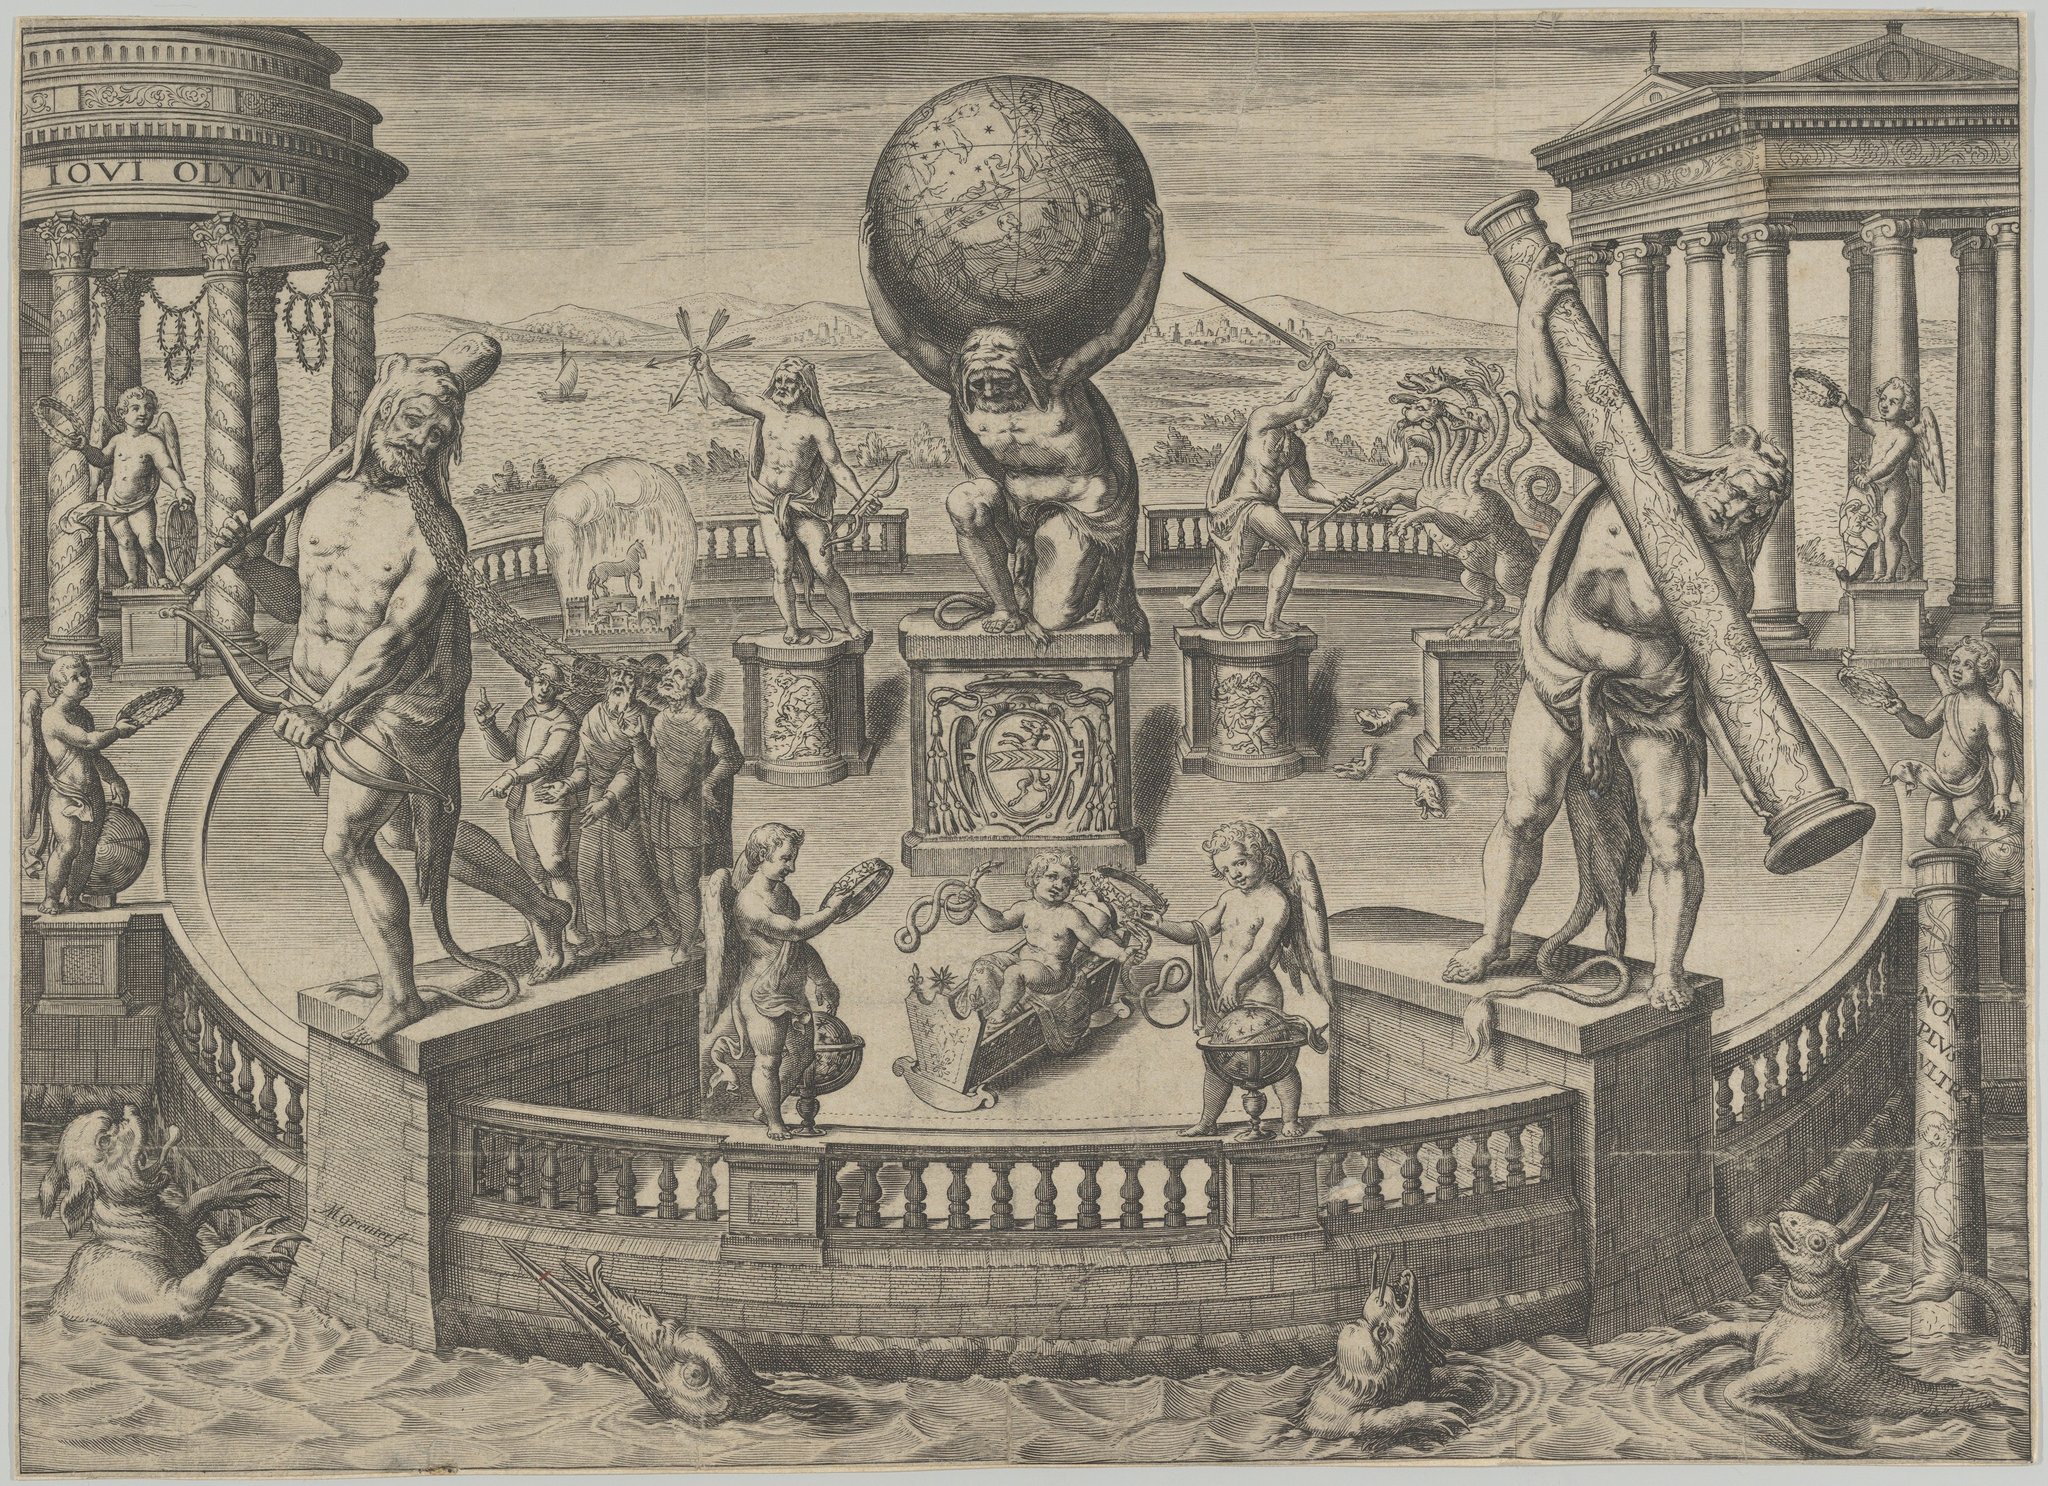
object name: print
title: Allegory of the Twelve Labors of Hercules Statues in a Circular Garden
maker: matthaeus greuter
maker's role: artist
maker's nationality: german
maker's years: 1566-1638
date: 1534-1666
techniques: engraving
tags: sculpture,gardens,bow and arrow,hercules,globes